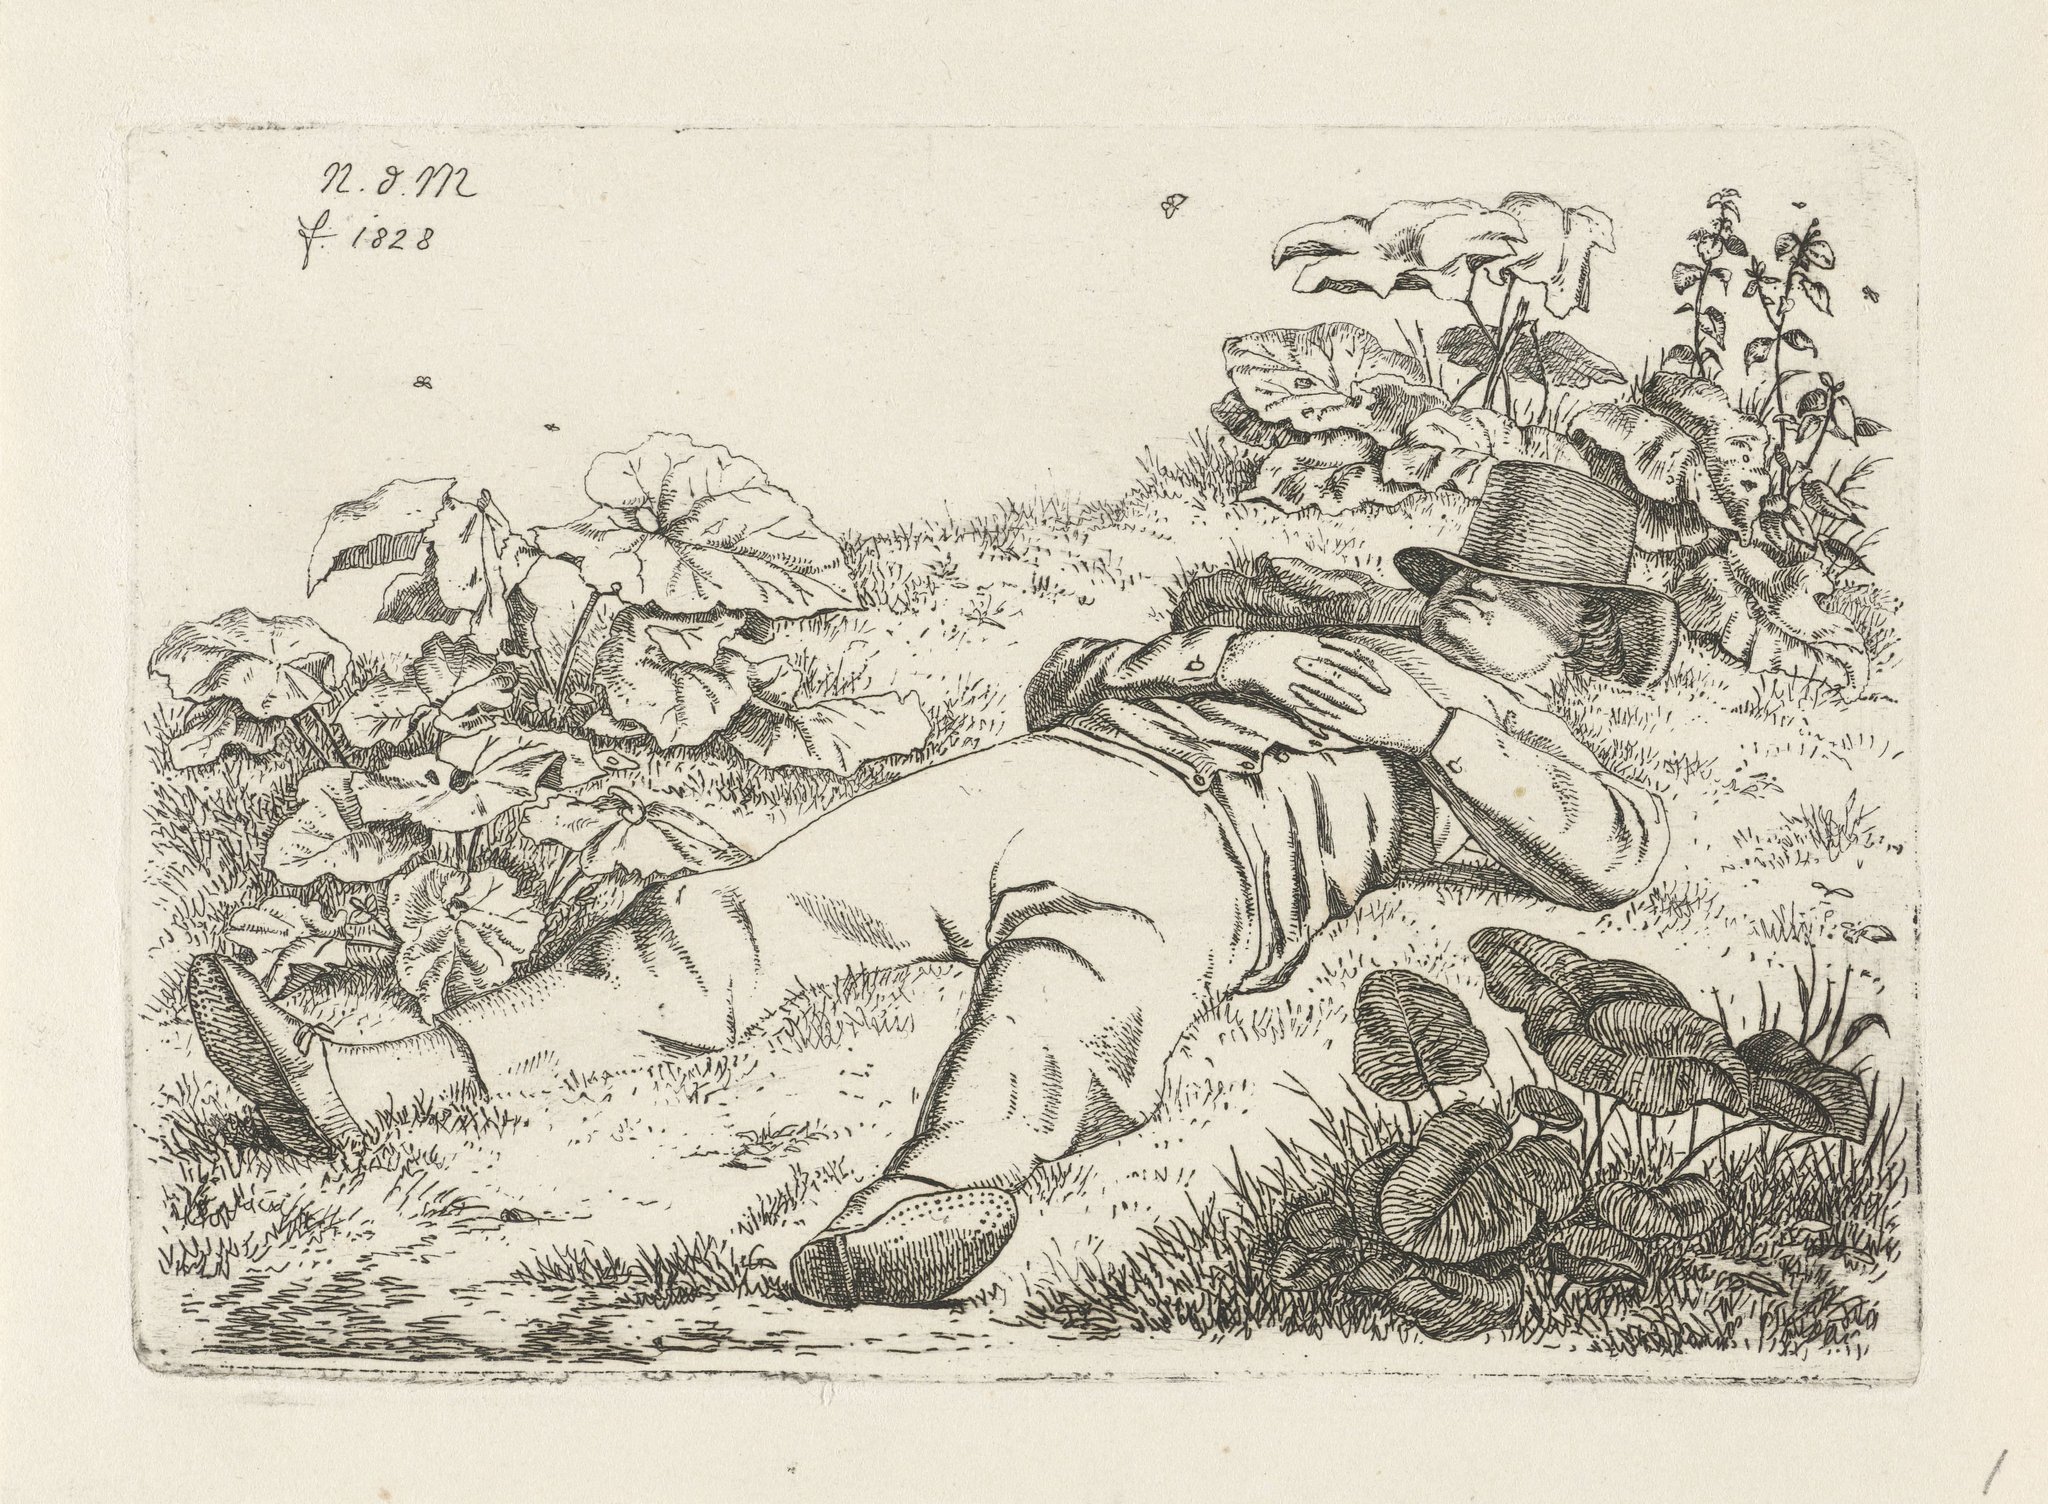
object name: print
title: Liggend man in het gras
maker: anthonie willem hendrik nolthenius de man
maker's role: draughtsman, print maker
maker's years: 1793-1842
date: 1828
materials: paper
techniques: etching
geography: the hague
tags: sleeping on the ground - bb - out of doors, lying figure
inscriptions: collector's mark: Lugt 2228